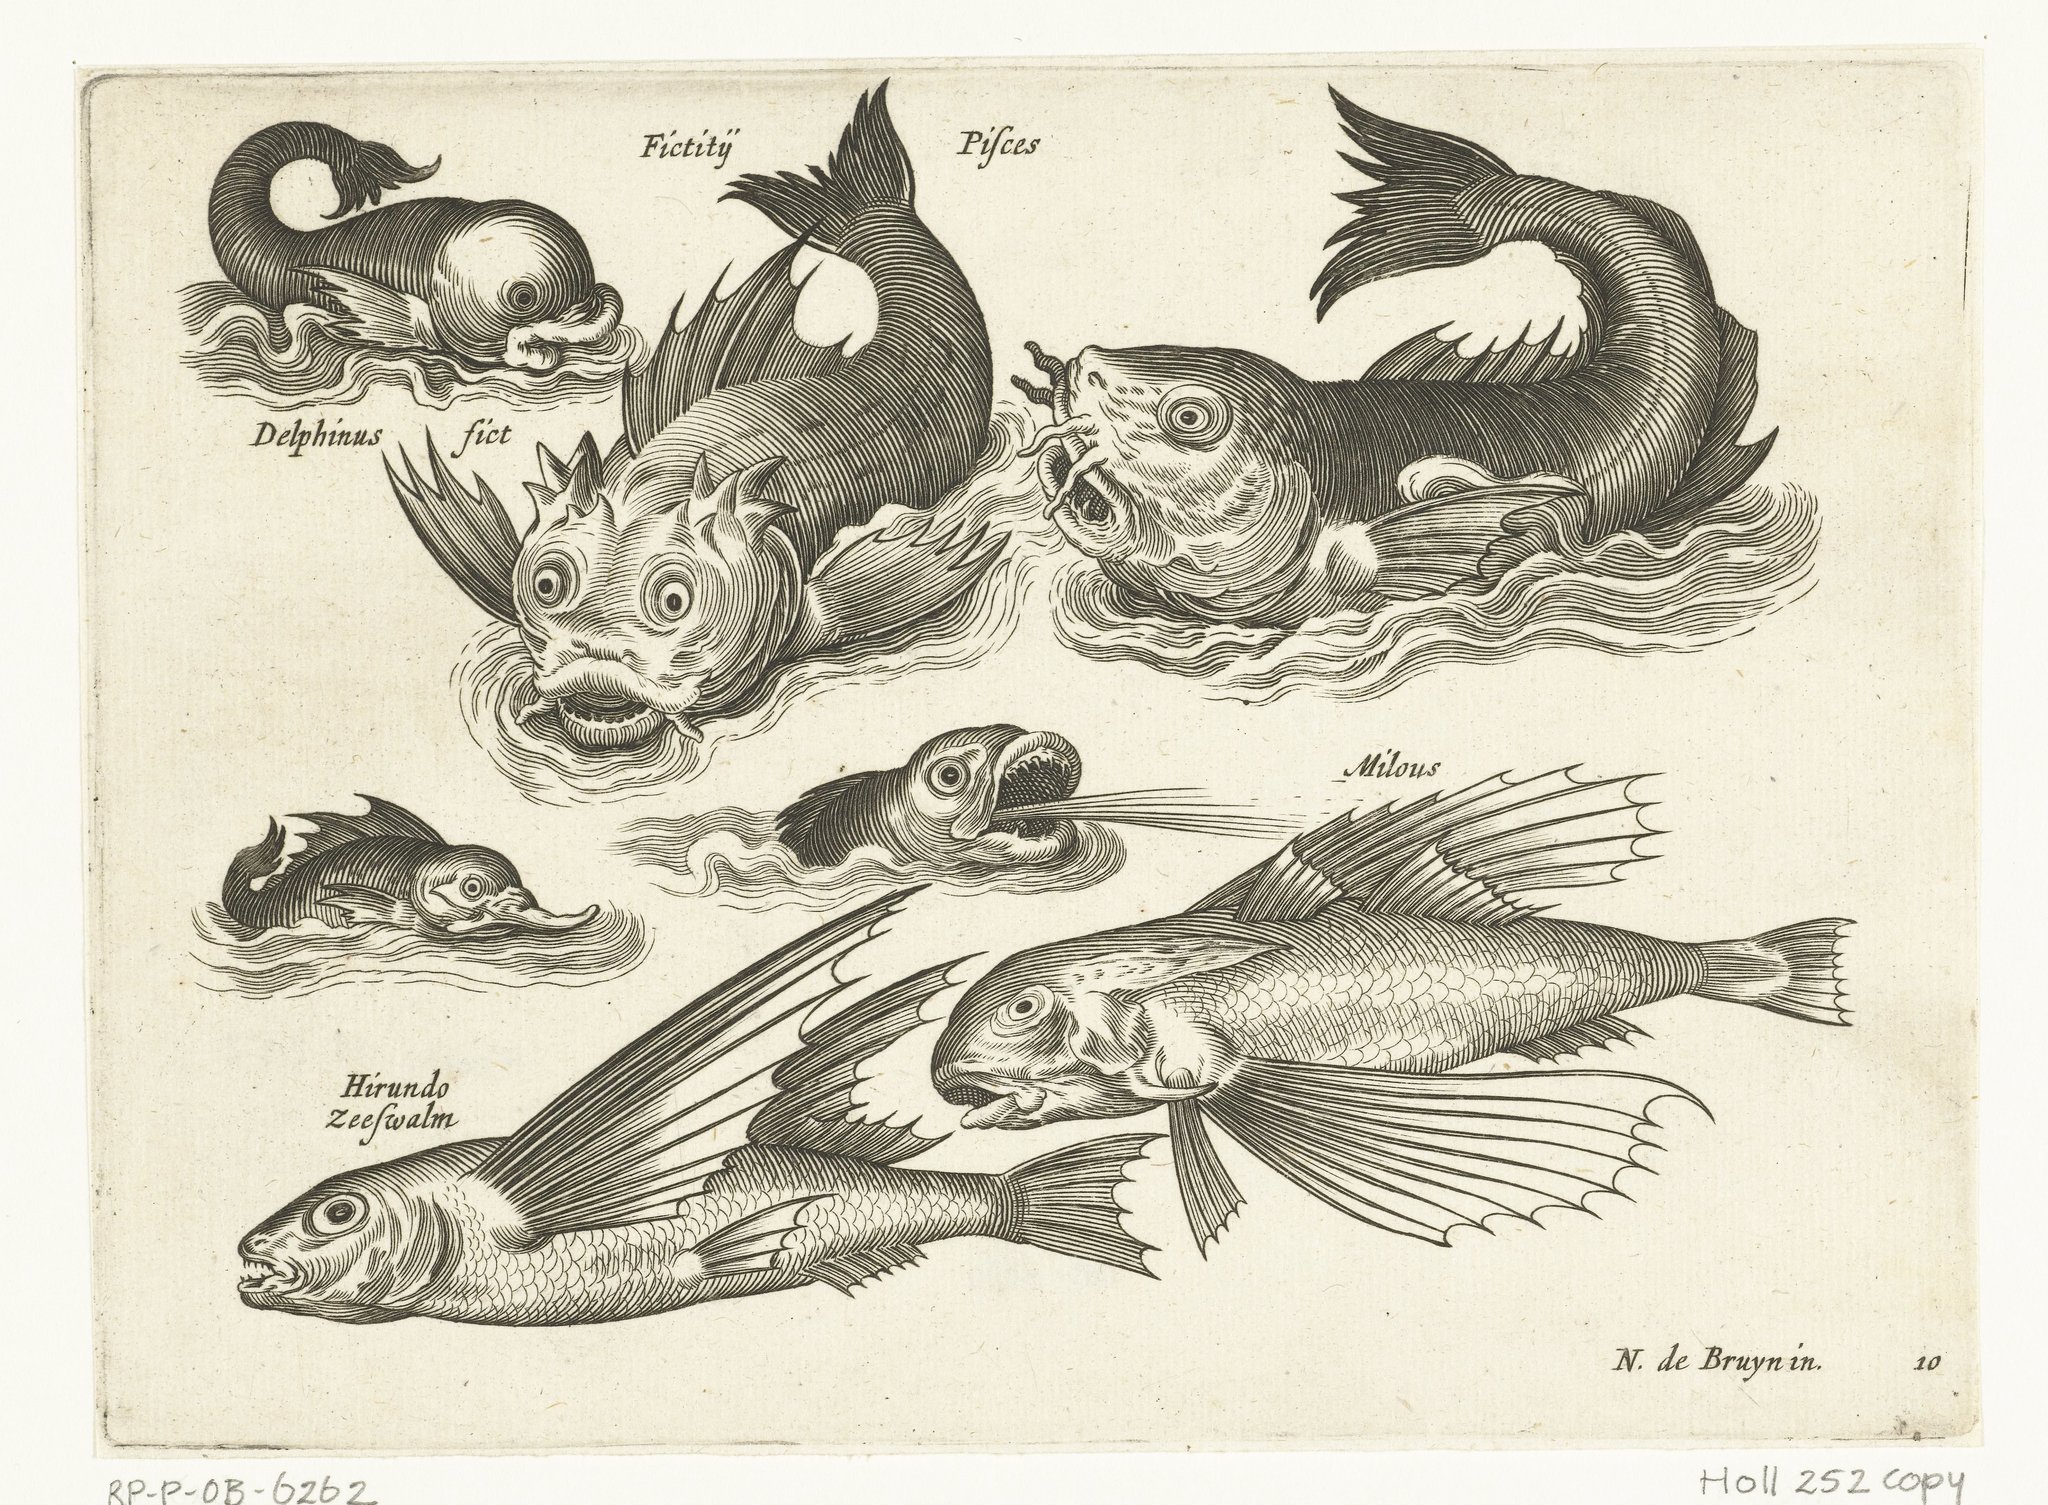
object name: print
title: Zoetwatervissen, zeevissen, kikkers, schaaldieren en zeewezens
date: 1581-1656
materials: paper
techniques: engraving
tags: fishes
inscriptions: collector's mark: Lugt 2228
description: Kopie naar prent van Nicolaes de Bruyn uit serie Libelivs varia Genera piscium complectens van dertien prenten met zoetwatervissen, zeevissen, kikkers, schaaldieren en zeewezens (inclusief titelprent).